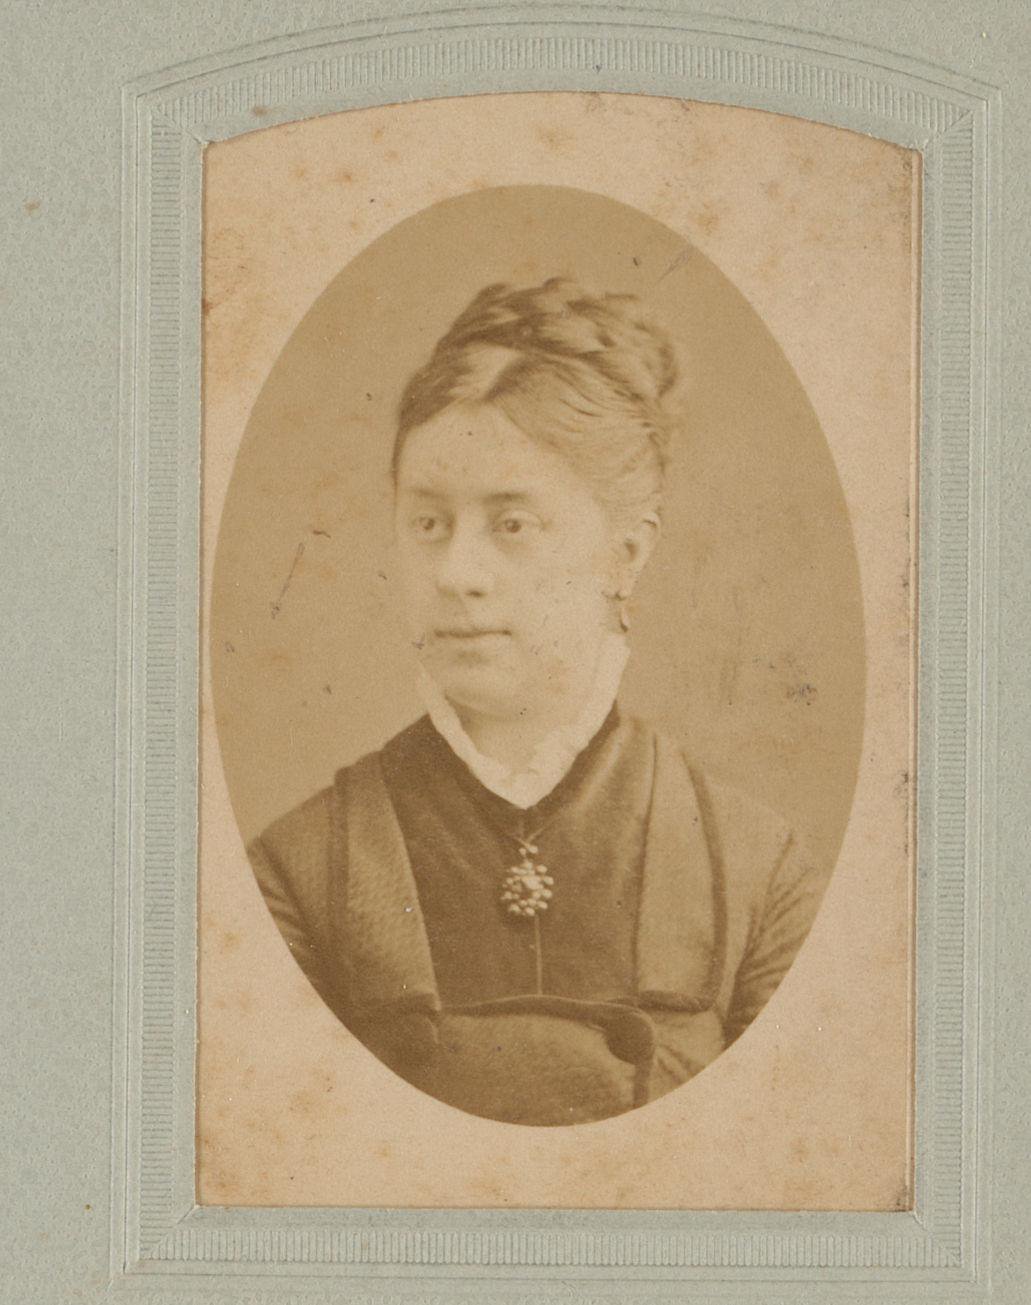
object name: photograph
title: Portret van een vrouw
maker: Anonymous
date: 1890-1910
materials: cardboard, photographic support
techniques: albumen print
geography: amsterdam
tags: adult woman, historical persons